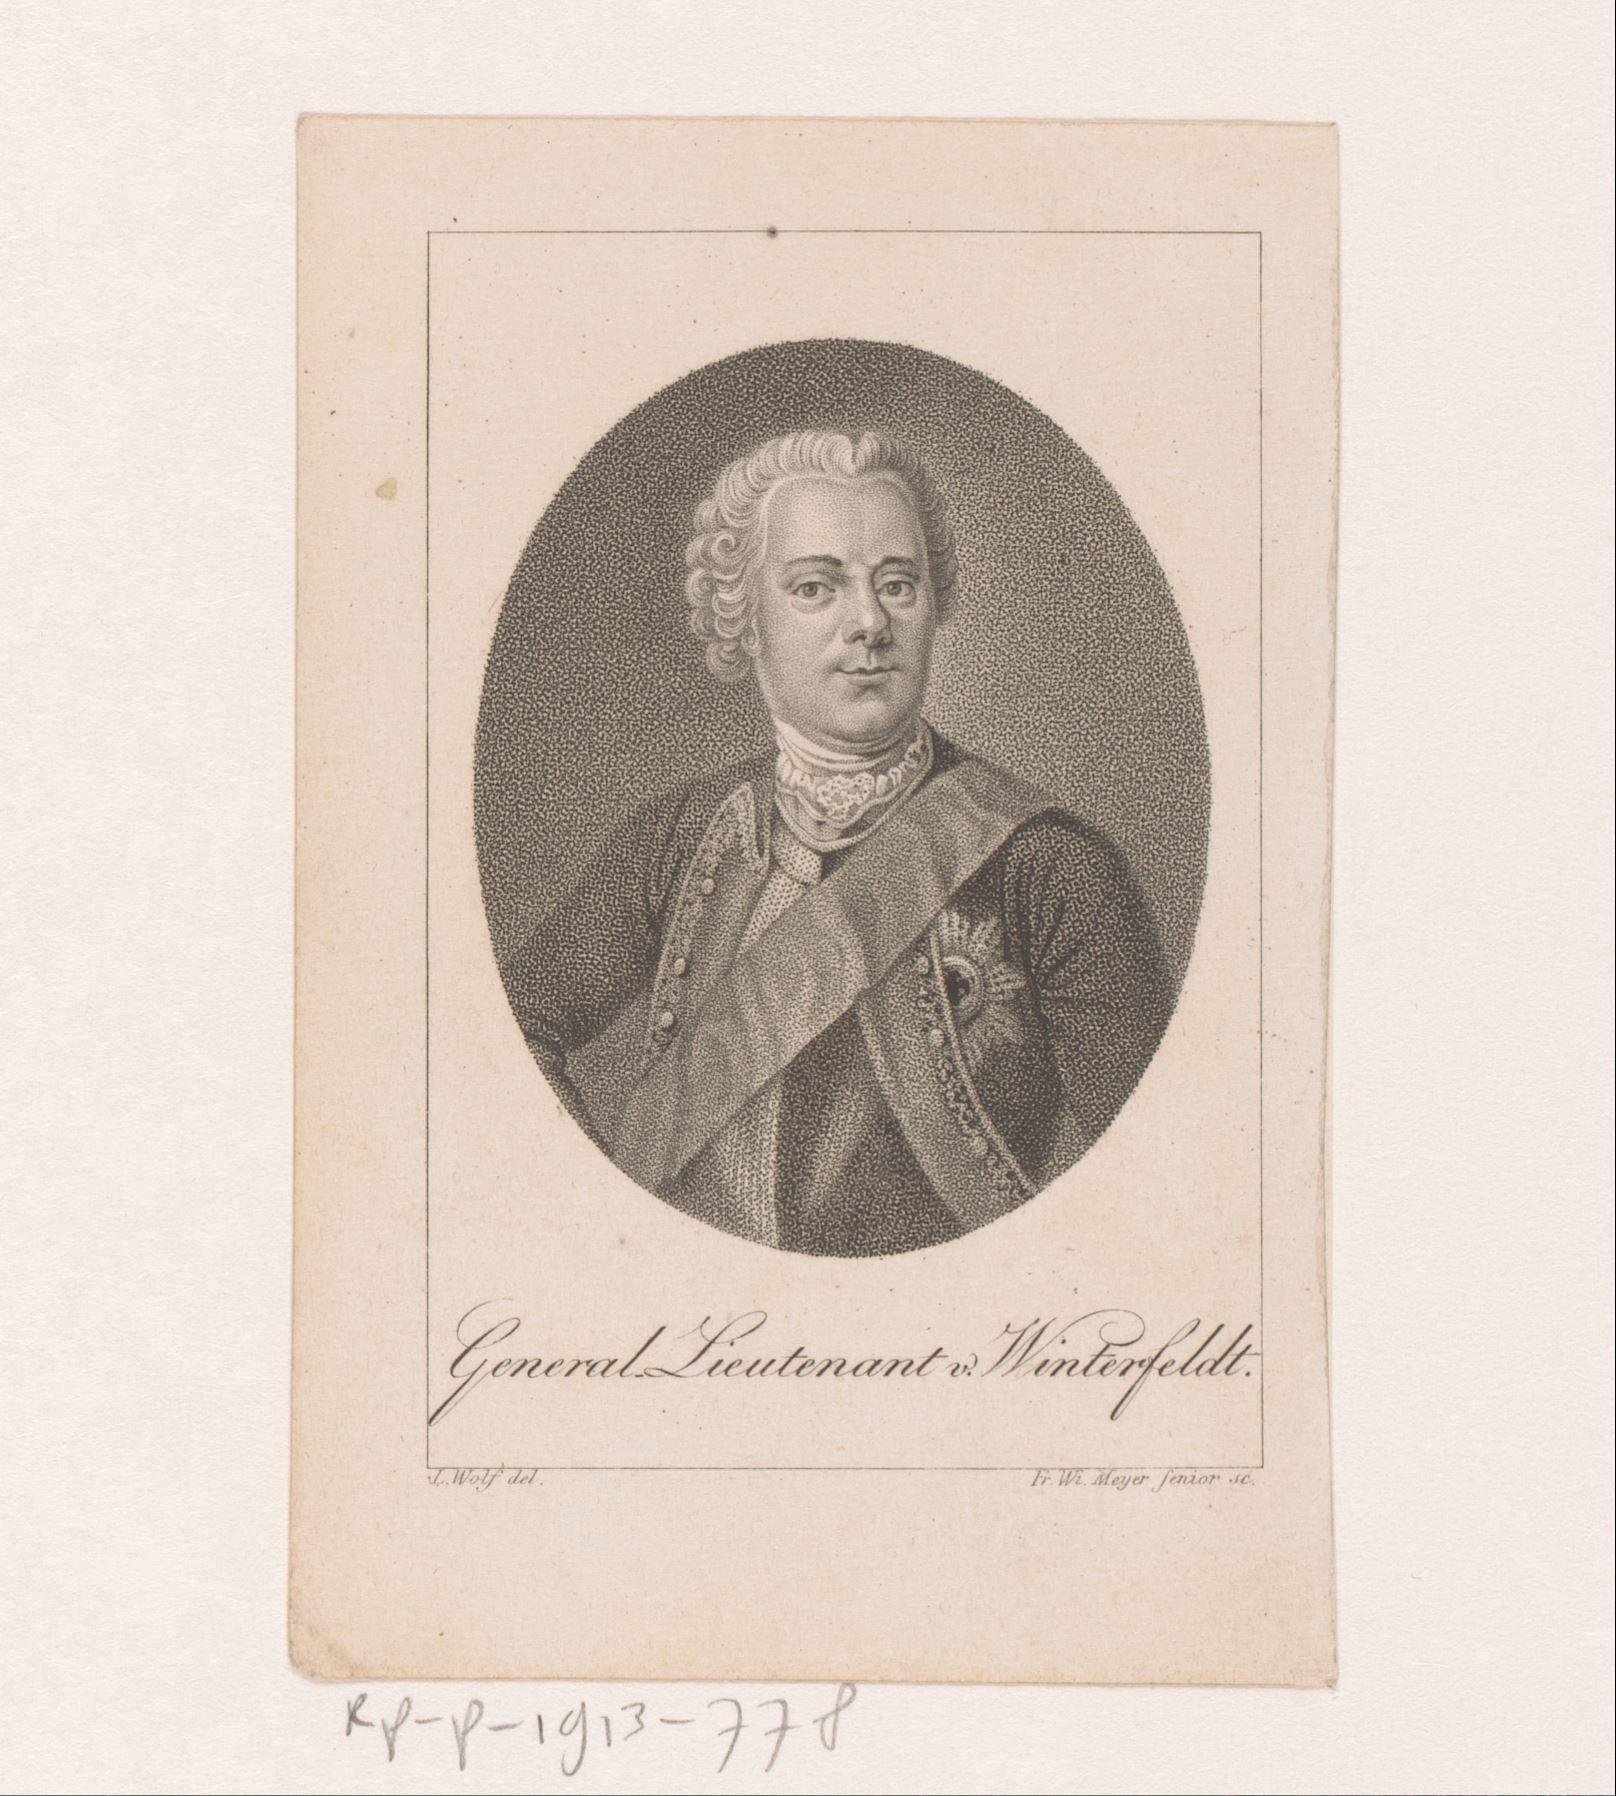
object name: print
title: Portret van Hans Carl von Winterfeldt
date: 1780-1880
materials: paper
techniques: engraving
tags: knighthood order (with name) - insignia of a knighthood order, e.g.: badge, chain (with name of order), historical persons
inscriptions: collector's mark: Lugt 2228